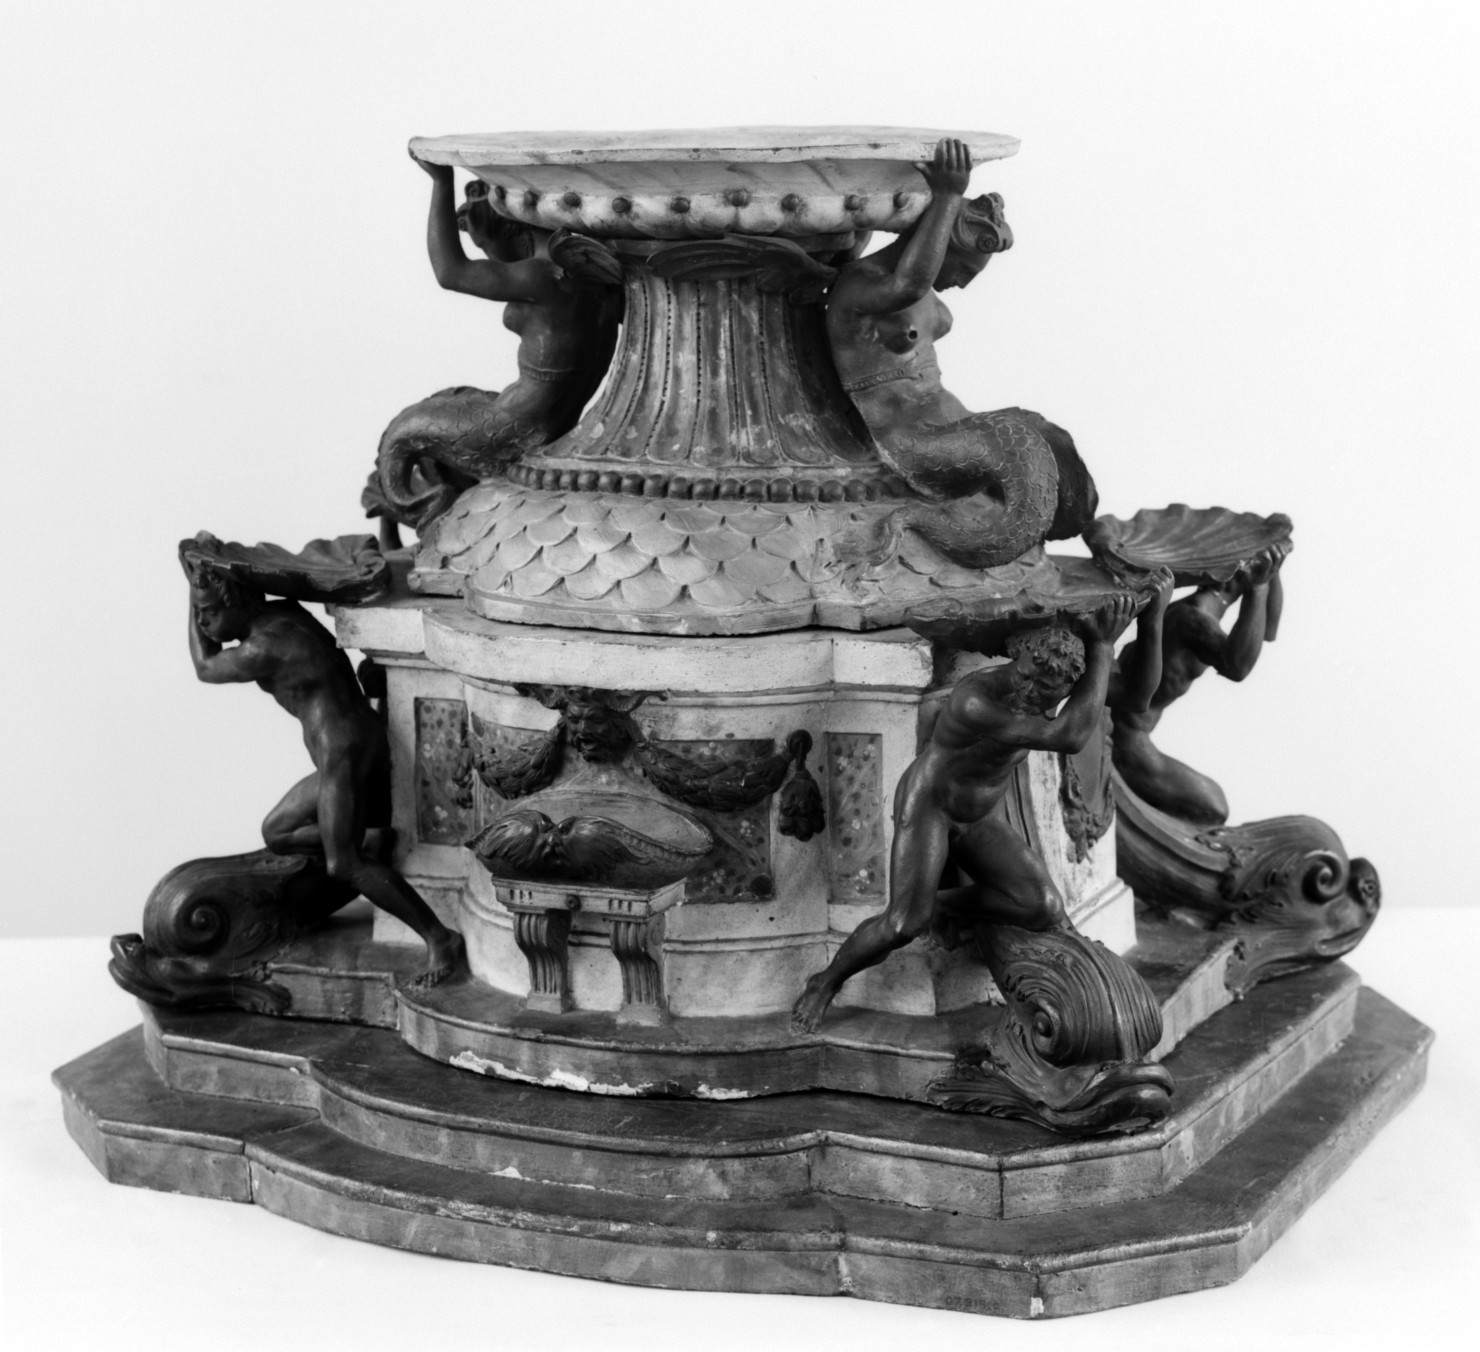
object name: fountain model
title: Model of a fountain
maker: giambologna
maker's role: artist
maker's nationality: netherlandish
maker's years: 1529-1608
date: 1501-1600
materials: terracotta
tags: animals,fountains,male nudes,mermaids